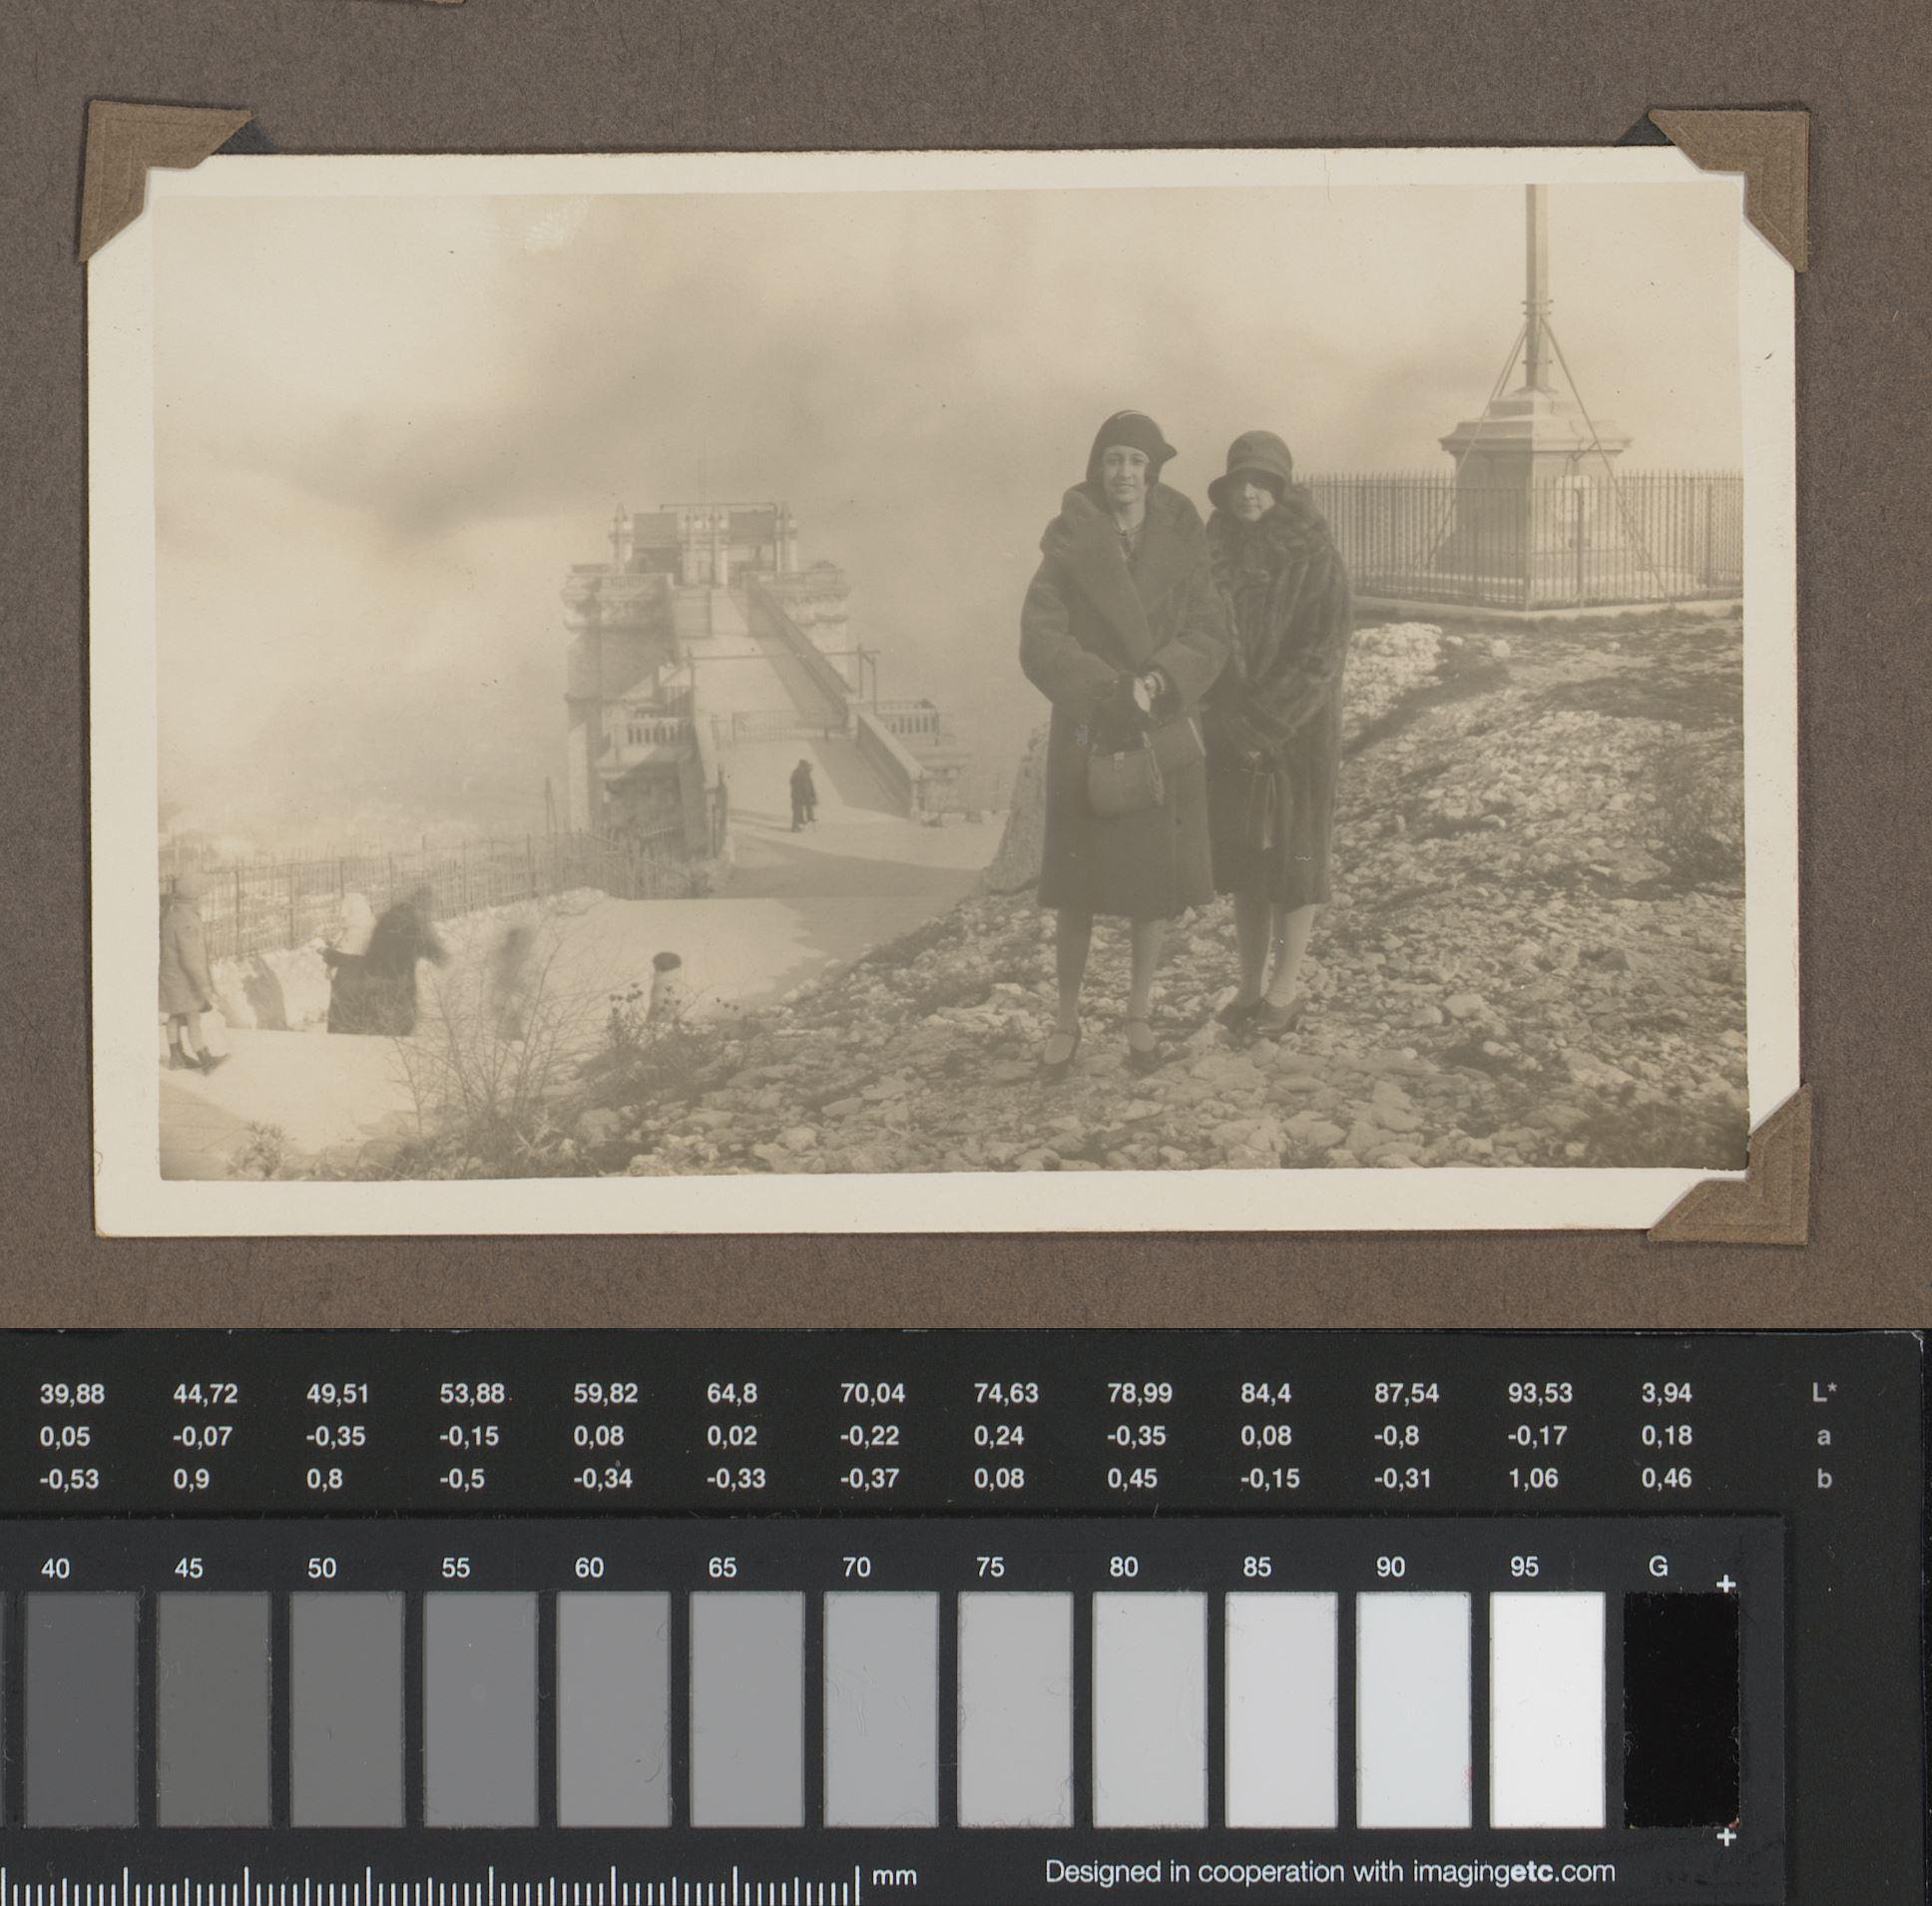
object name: photograph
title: Dootje van Zijll de Jong en Henriëtte Wassin op een heuvel bij een monument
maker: Anonymous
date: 1930-1935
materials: paper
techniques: gelatin silver print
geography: europe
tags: henriëtte wassink, amsterdam, adult woman, (high) hill, europe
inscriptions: inscription: ‘Carte Postale’